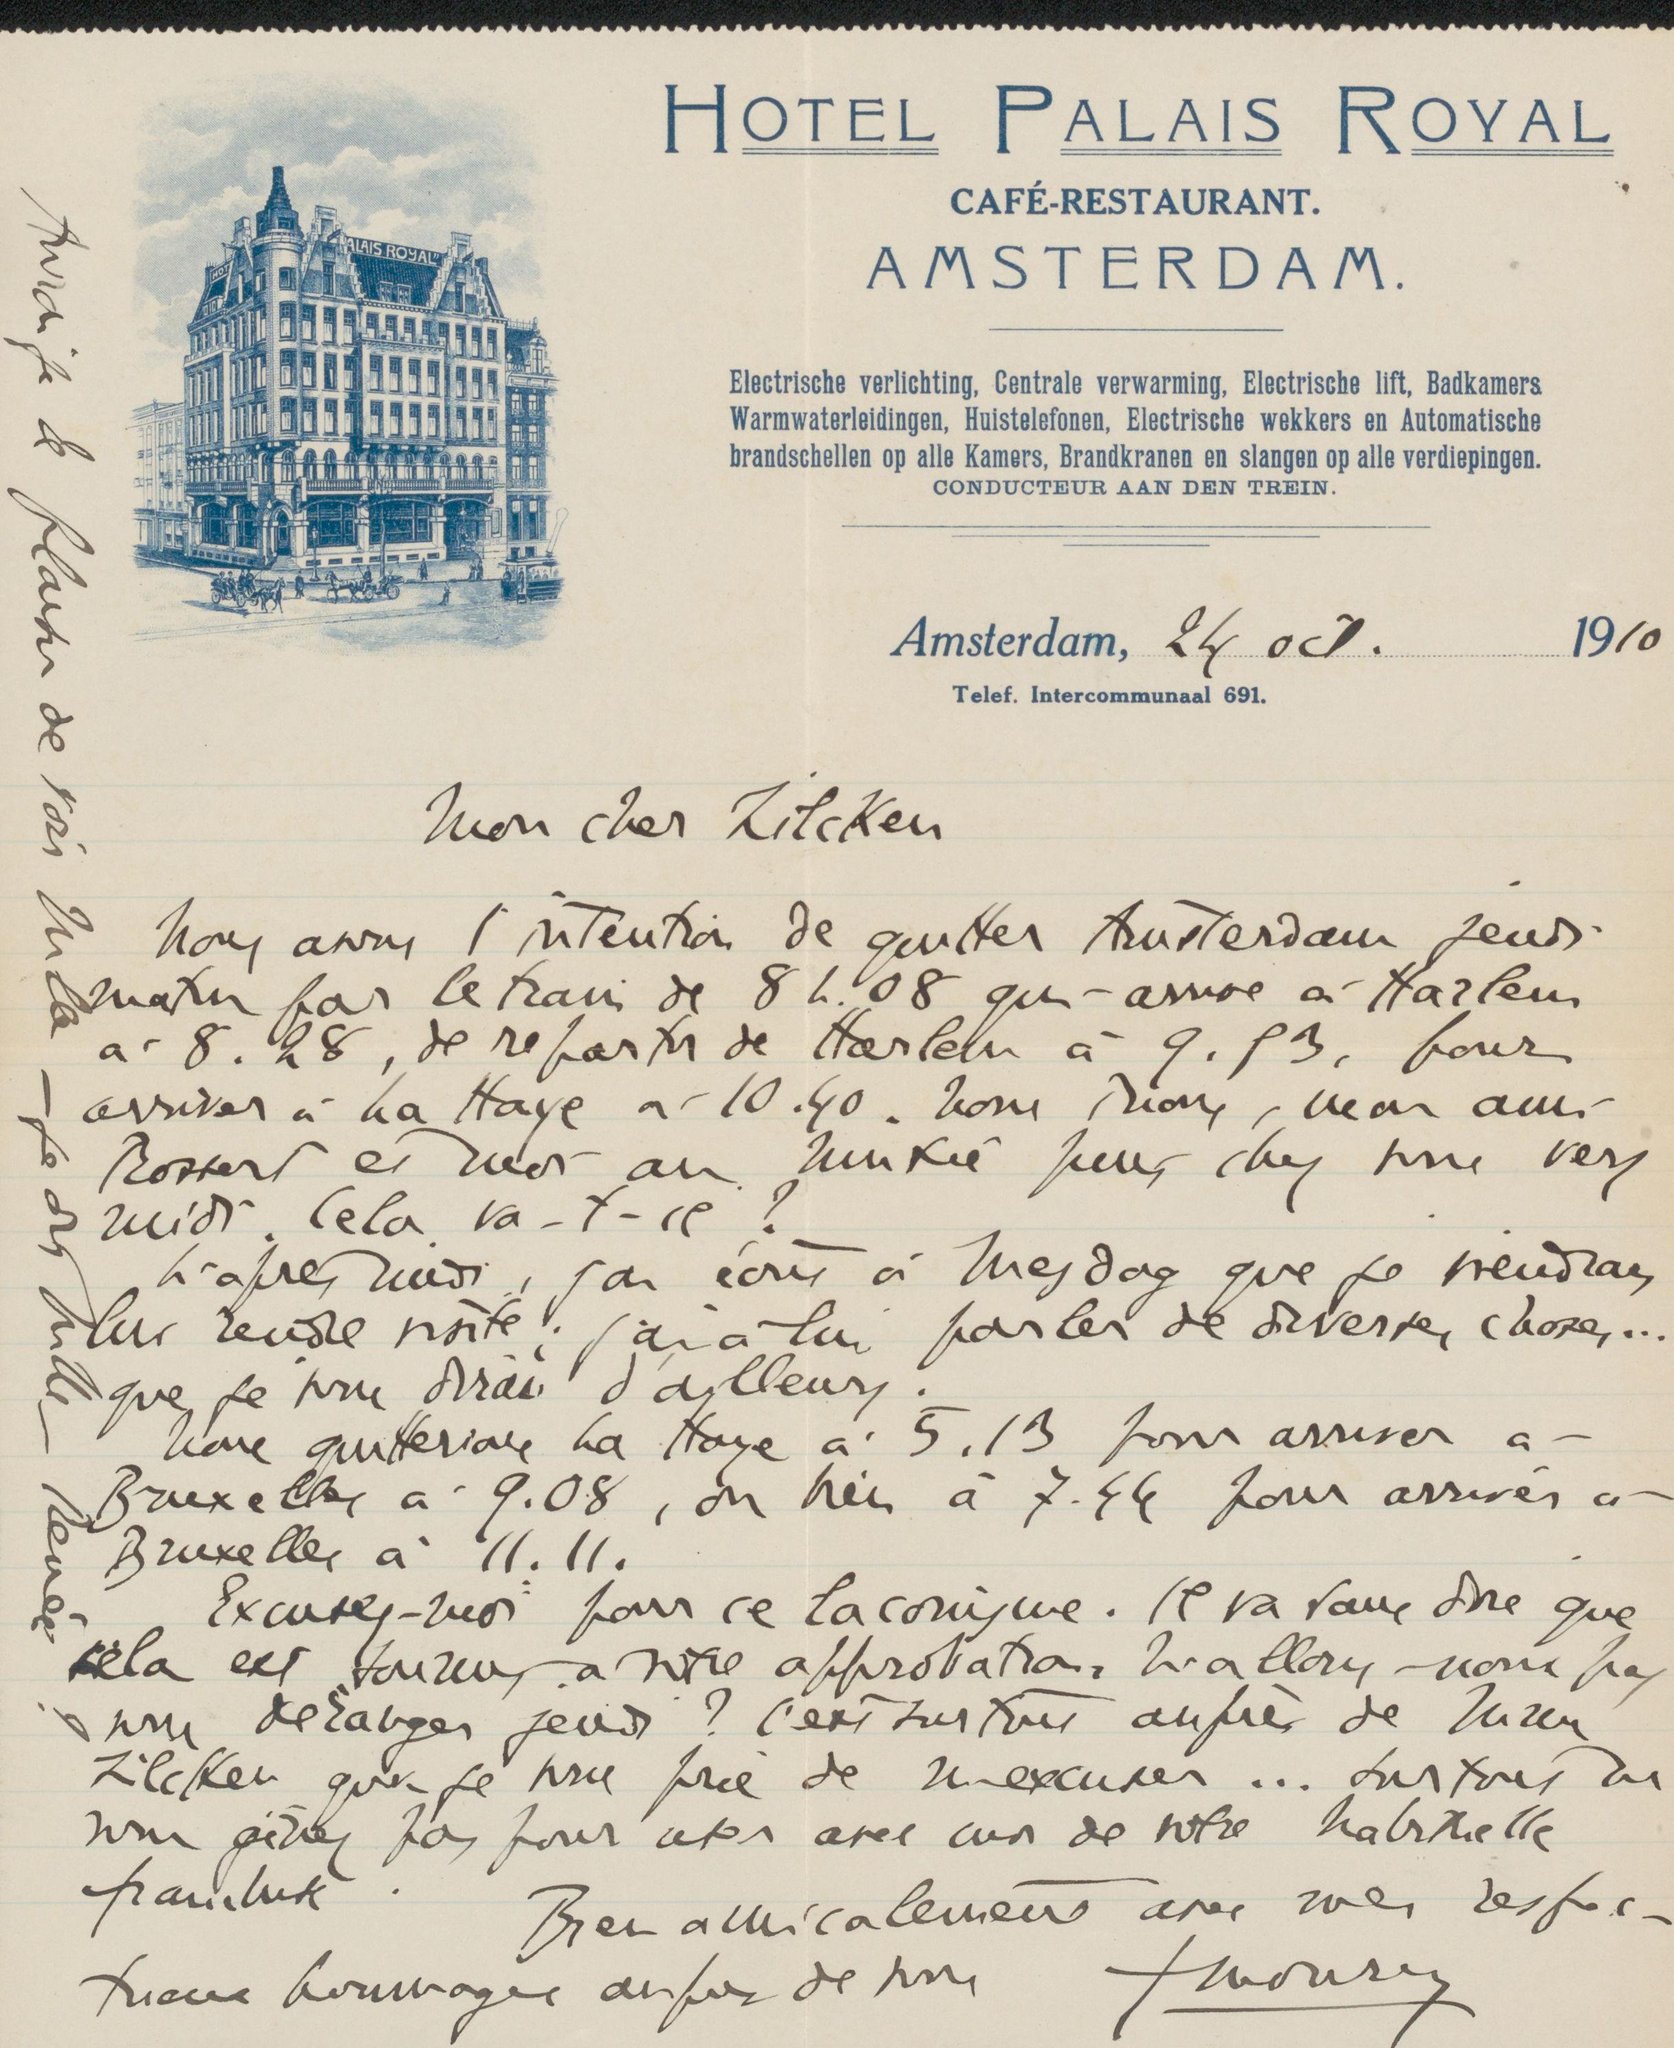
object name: letter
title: Brief aan Philip Zilcken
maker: gabriel mourey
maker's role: criticus, schrijver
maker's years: 1865-1943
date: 1910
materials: ink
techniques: pen, printing, writing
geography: amsterdam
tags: painter, print maker, draughtsman, hendrik willem mesdag, philip zilcken, the hague, brussels, amsterdam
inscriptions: collector's mark: ‘RPK’